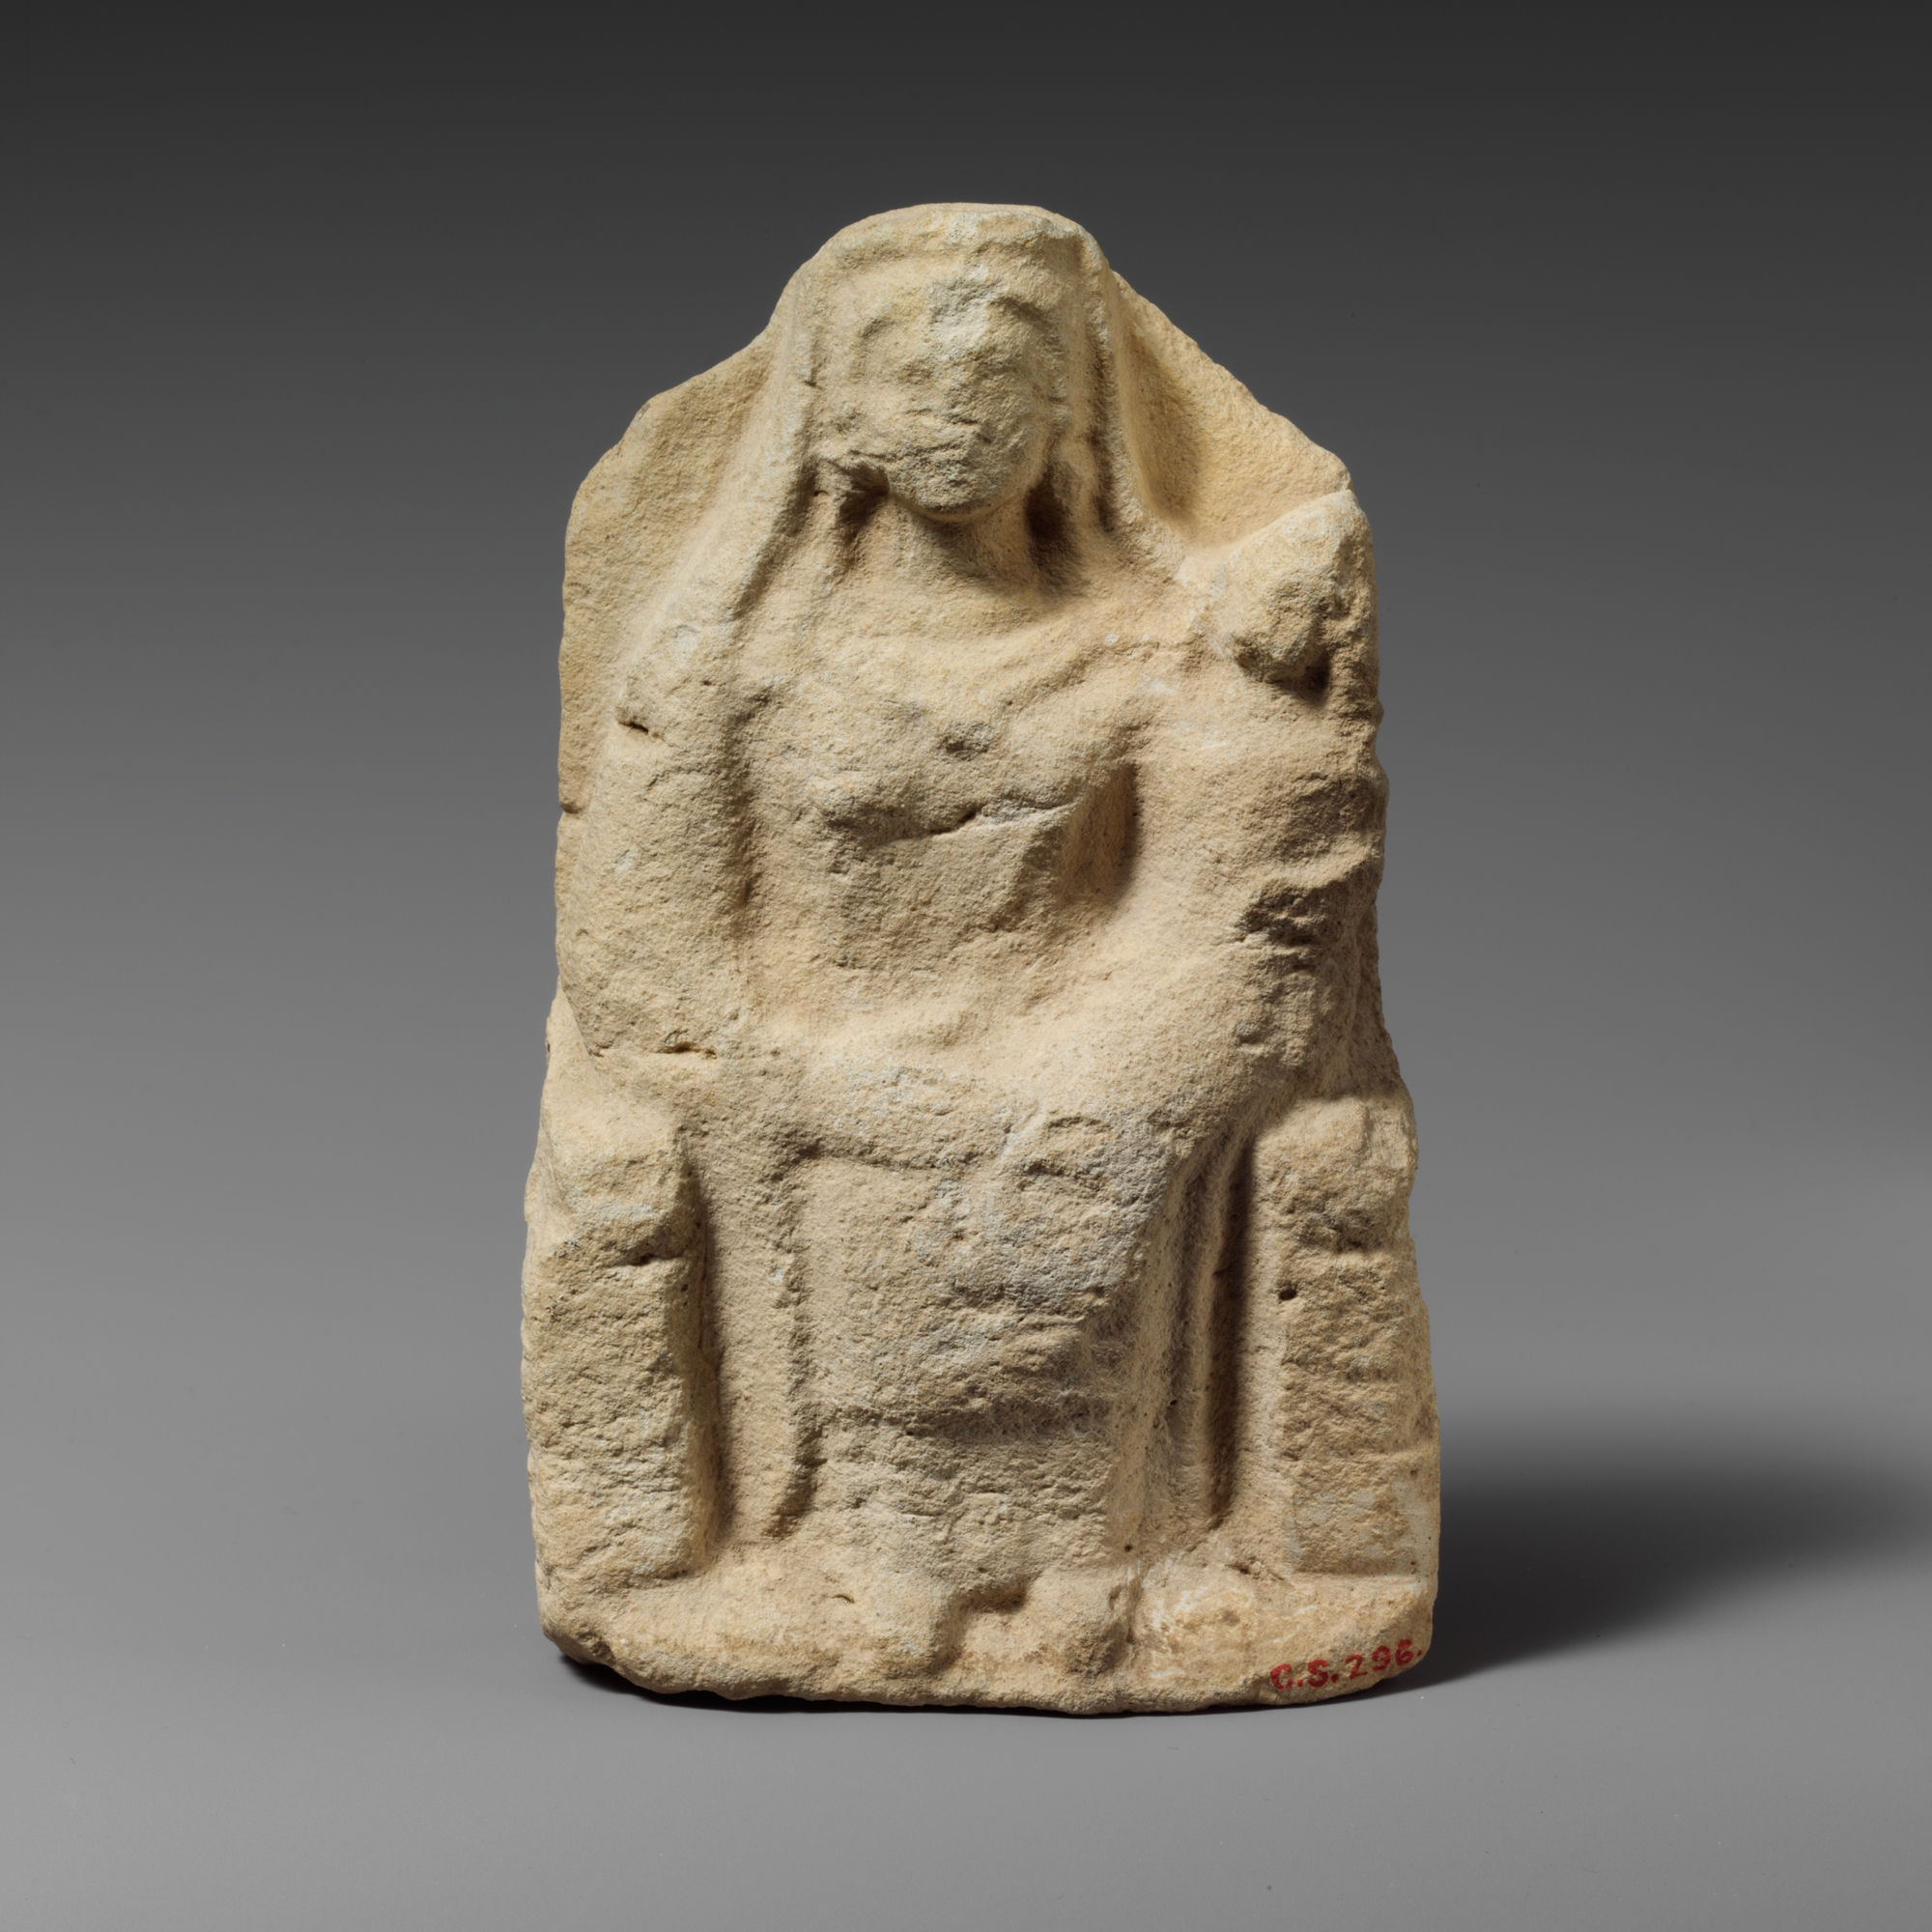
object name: statuette of a woman nursing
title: Seated limestone kourotrophos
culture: cypriot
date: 400-301 BCE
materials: limestone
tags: infants,women